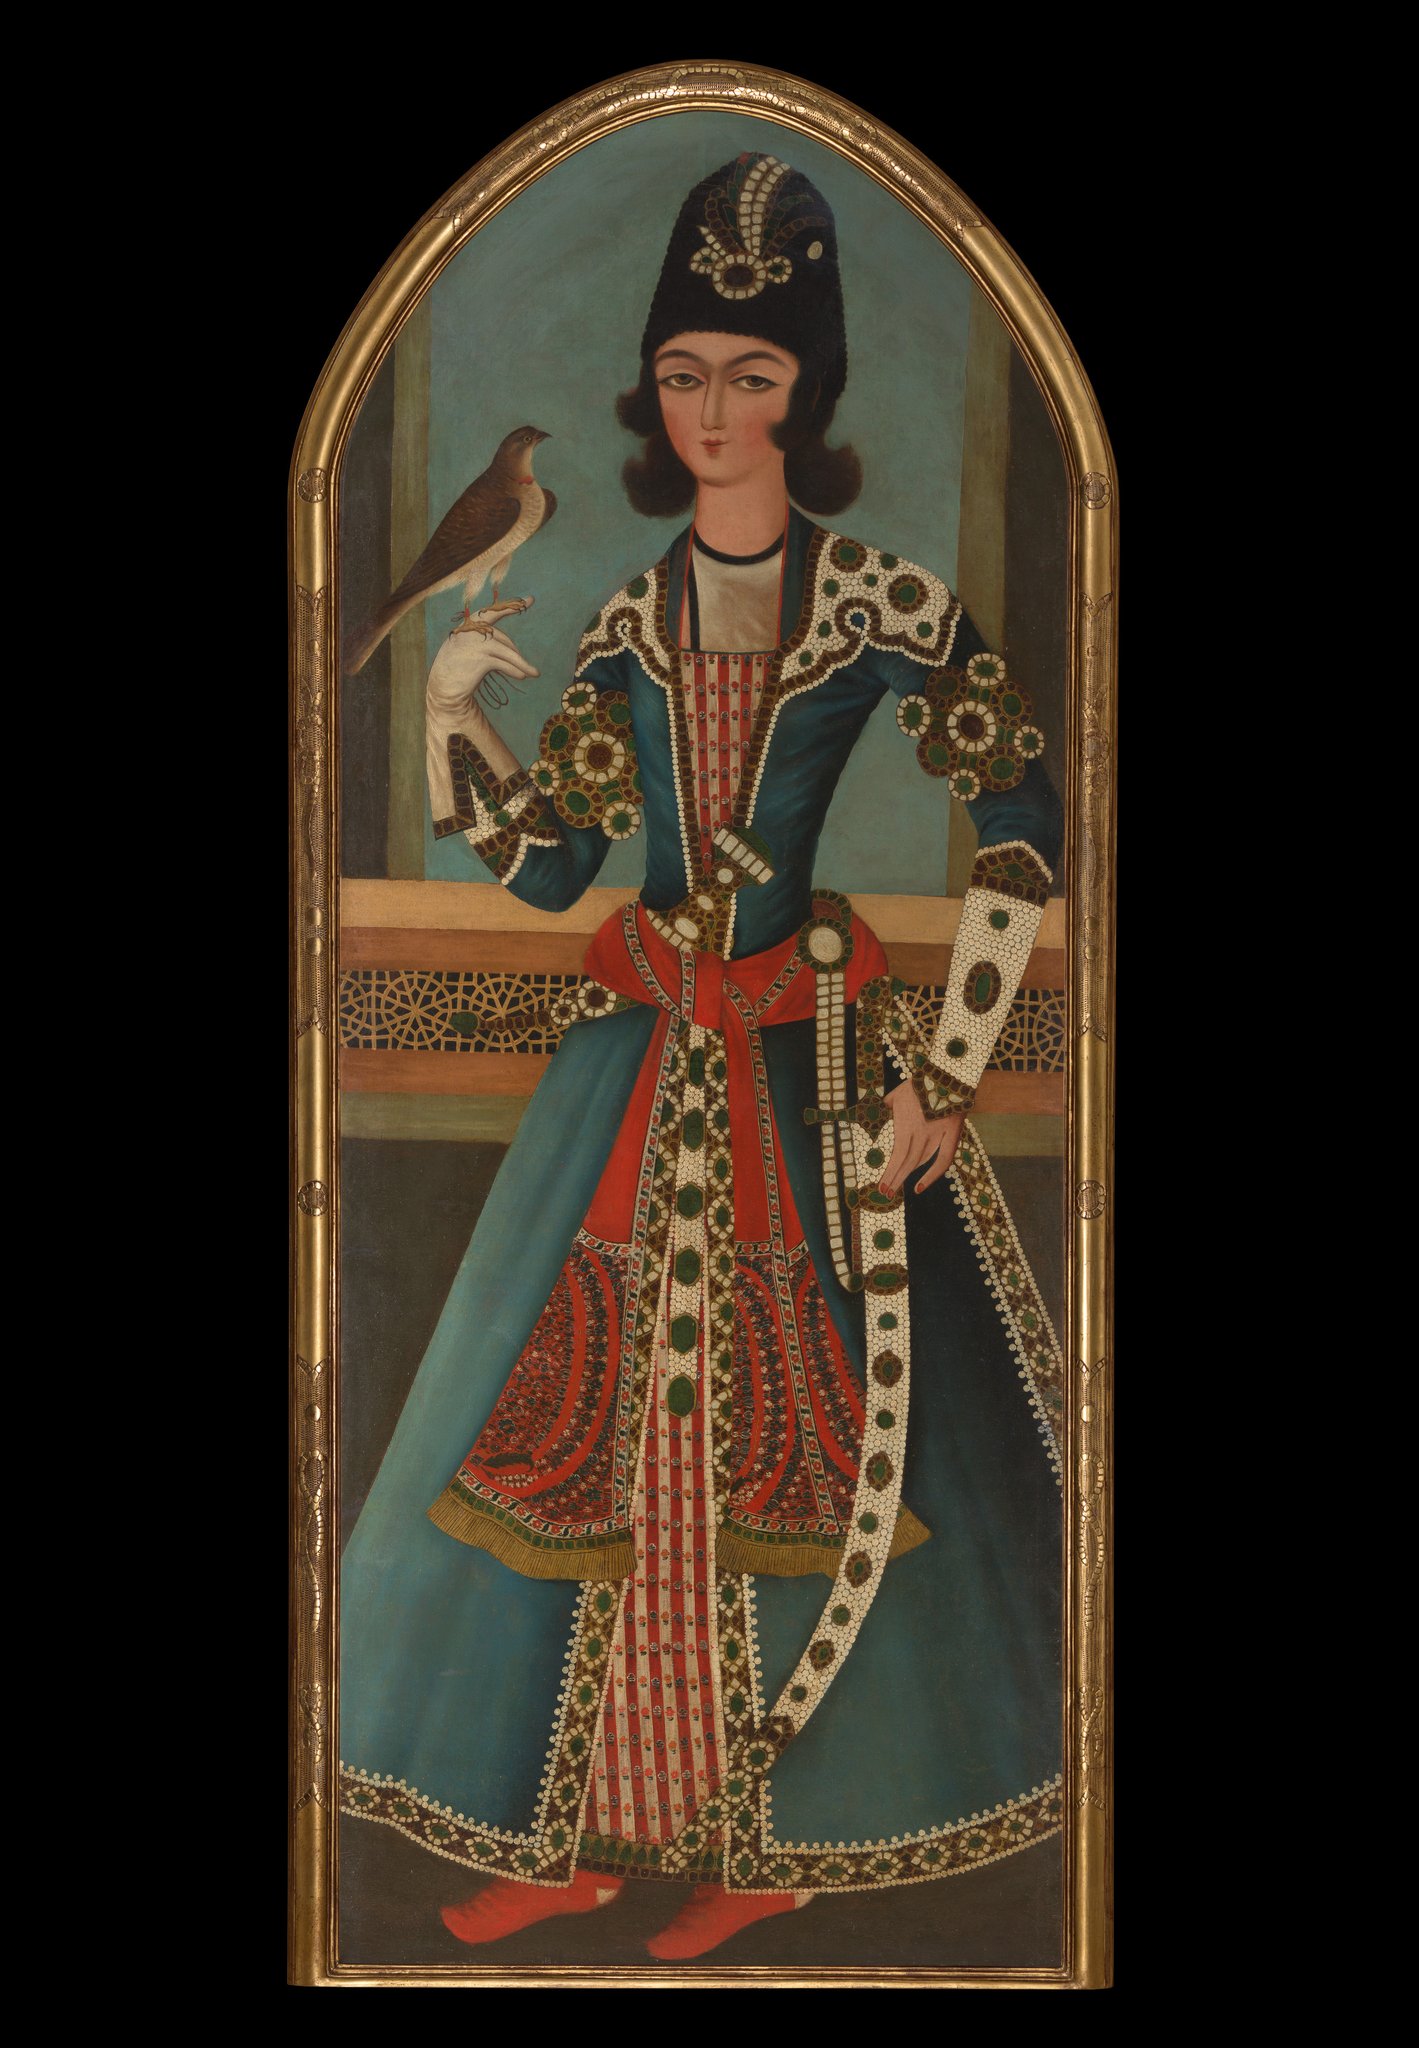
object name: painting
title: Prince Holding a Falcon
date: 1820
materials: canvas, oil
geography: iran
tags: falcons,princes,men,portraits